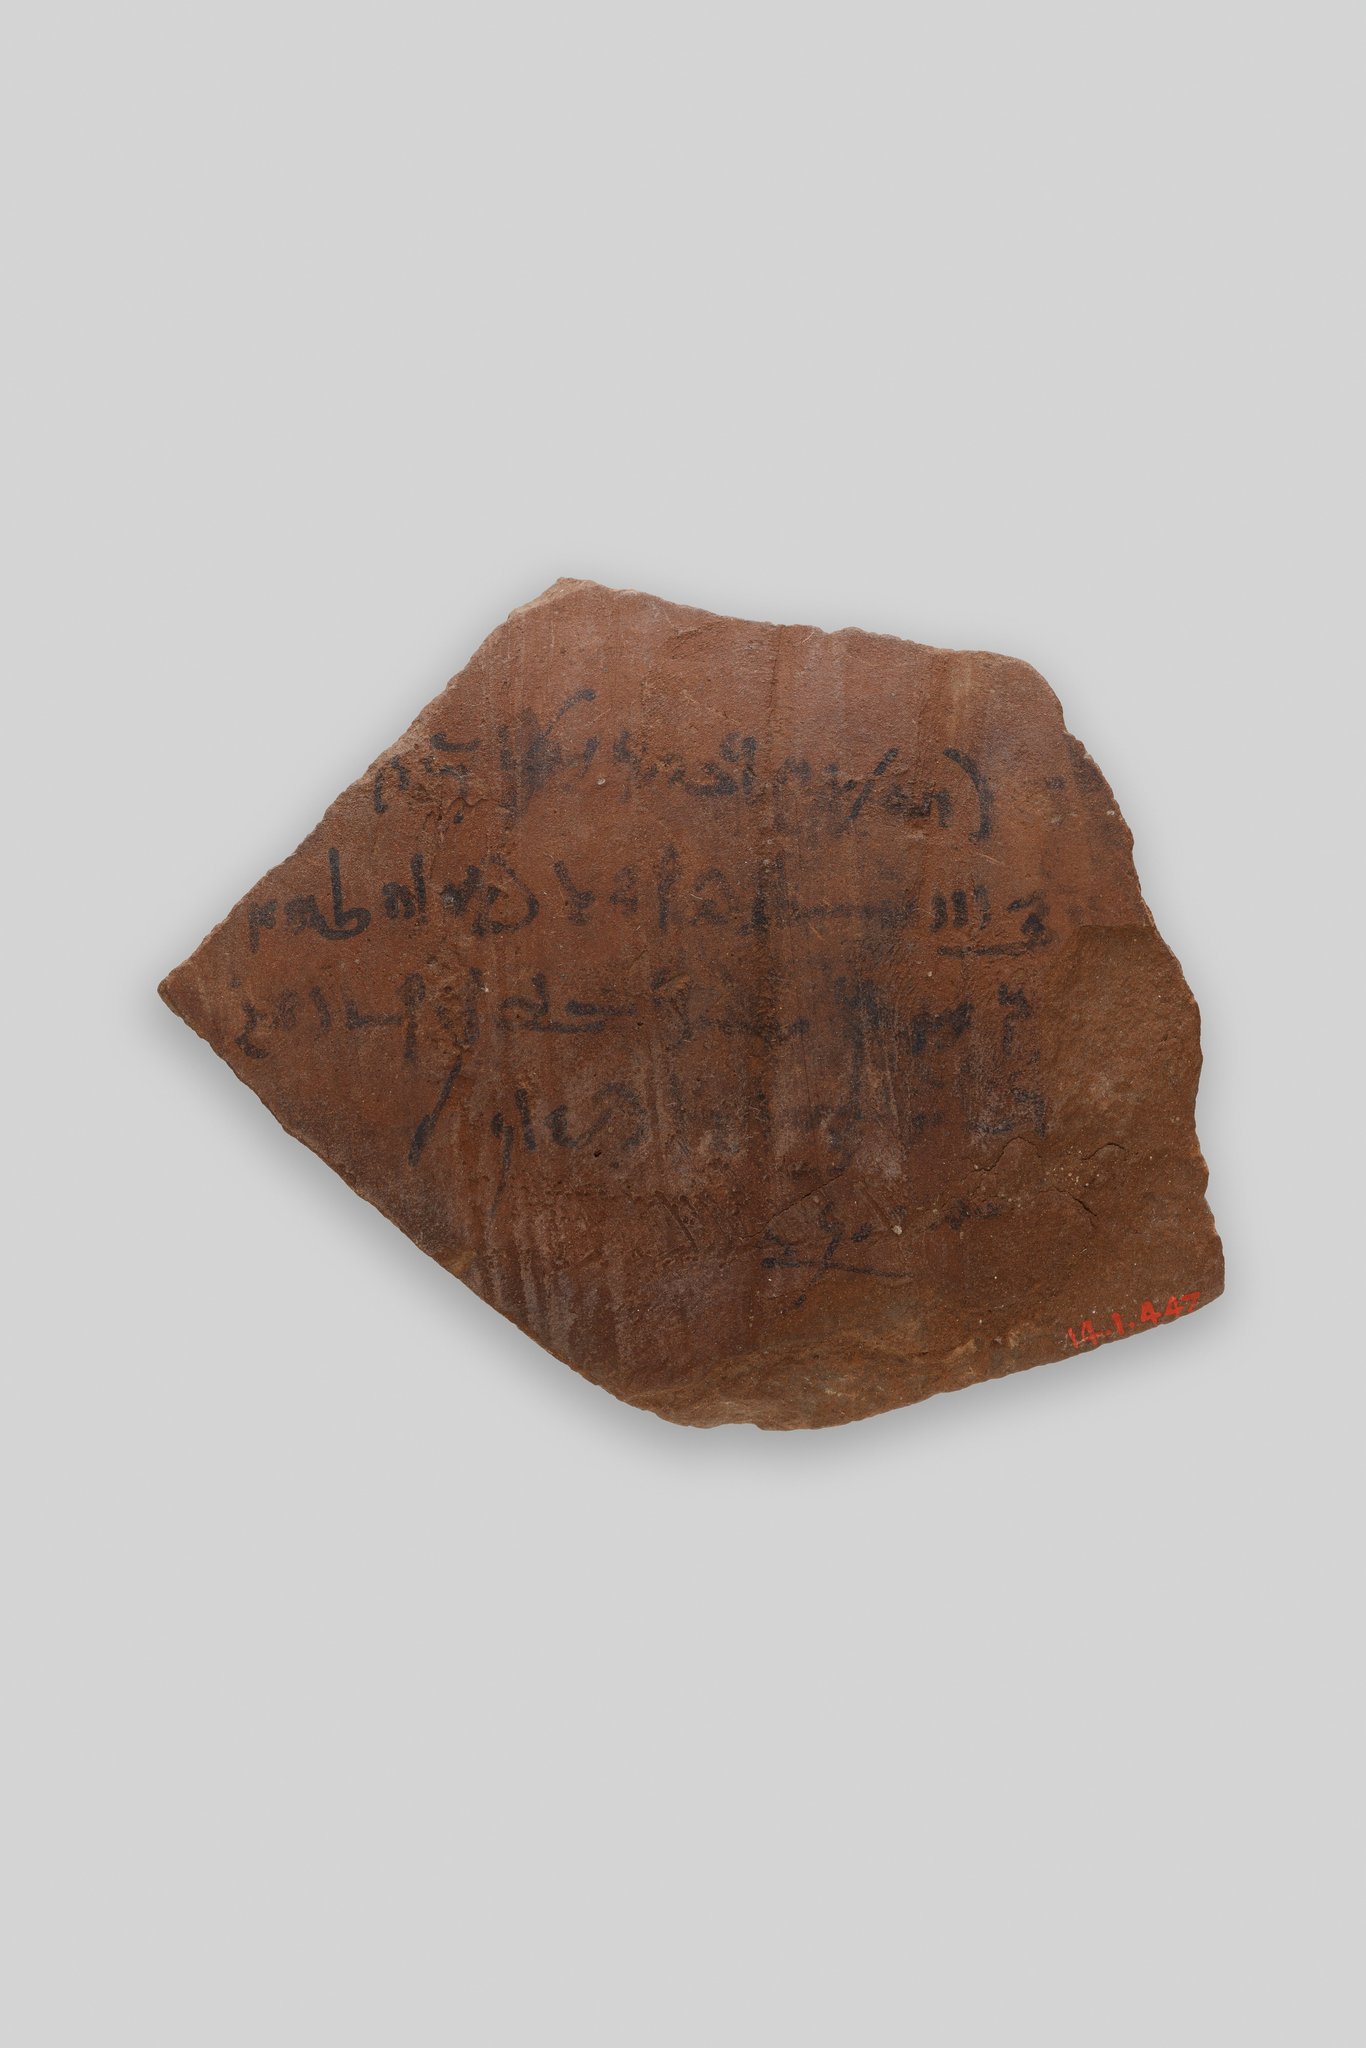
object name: ostracon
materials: ink, pottery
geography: egypt